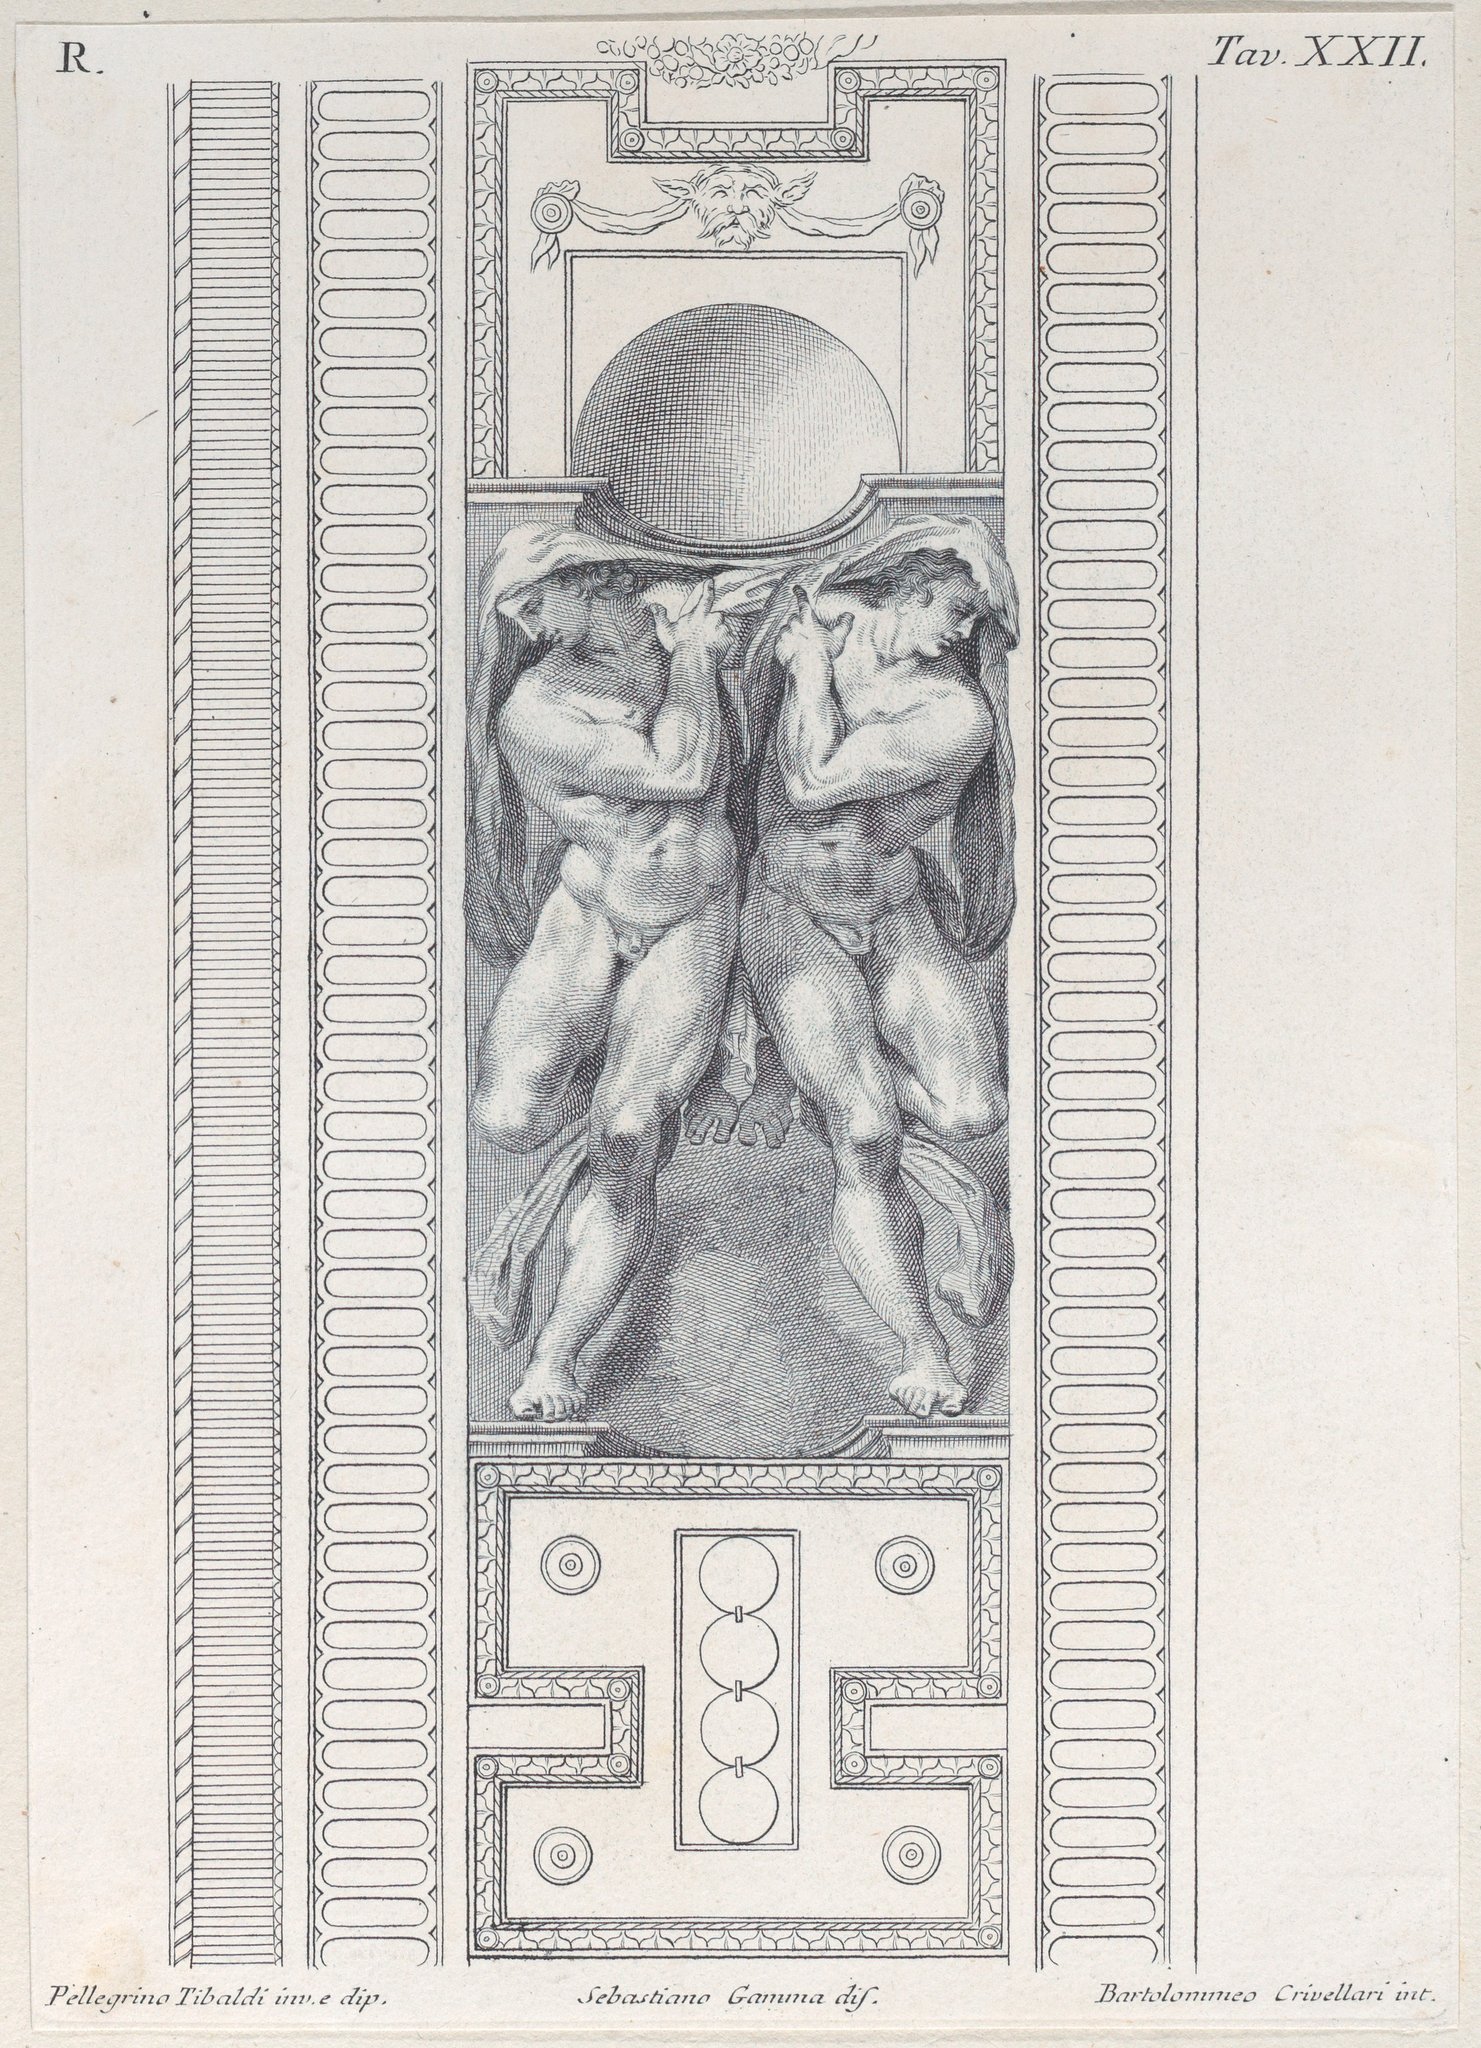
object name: print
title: Plate 22: two nude figures wearing veils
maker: bartolomeo crivellari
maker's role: artist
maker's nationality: italian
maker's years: 1700-1800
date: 1756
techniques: engraving, etching